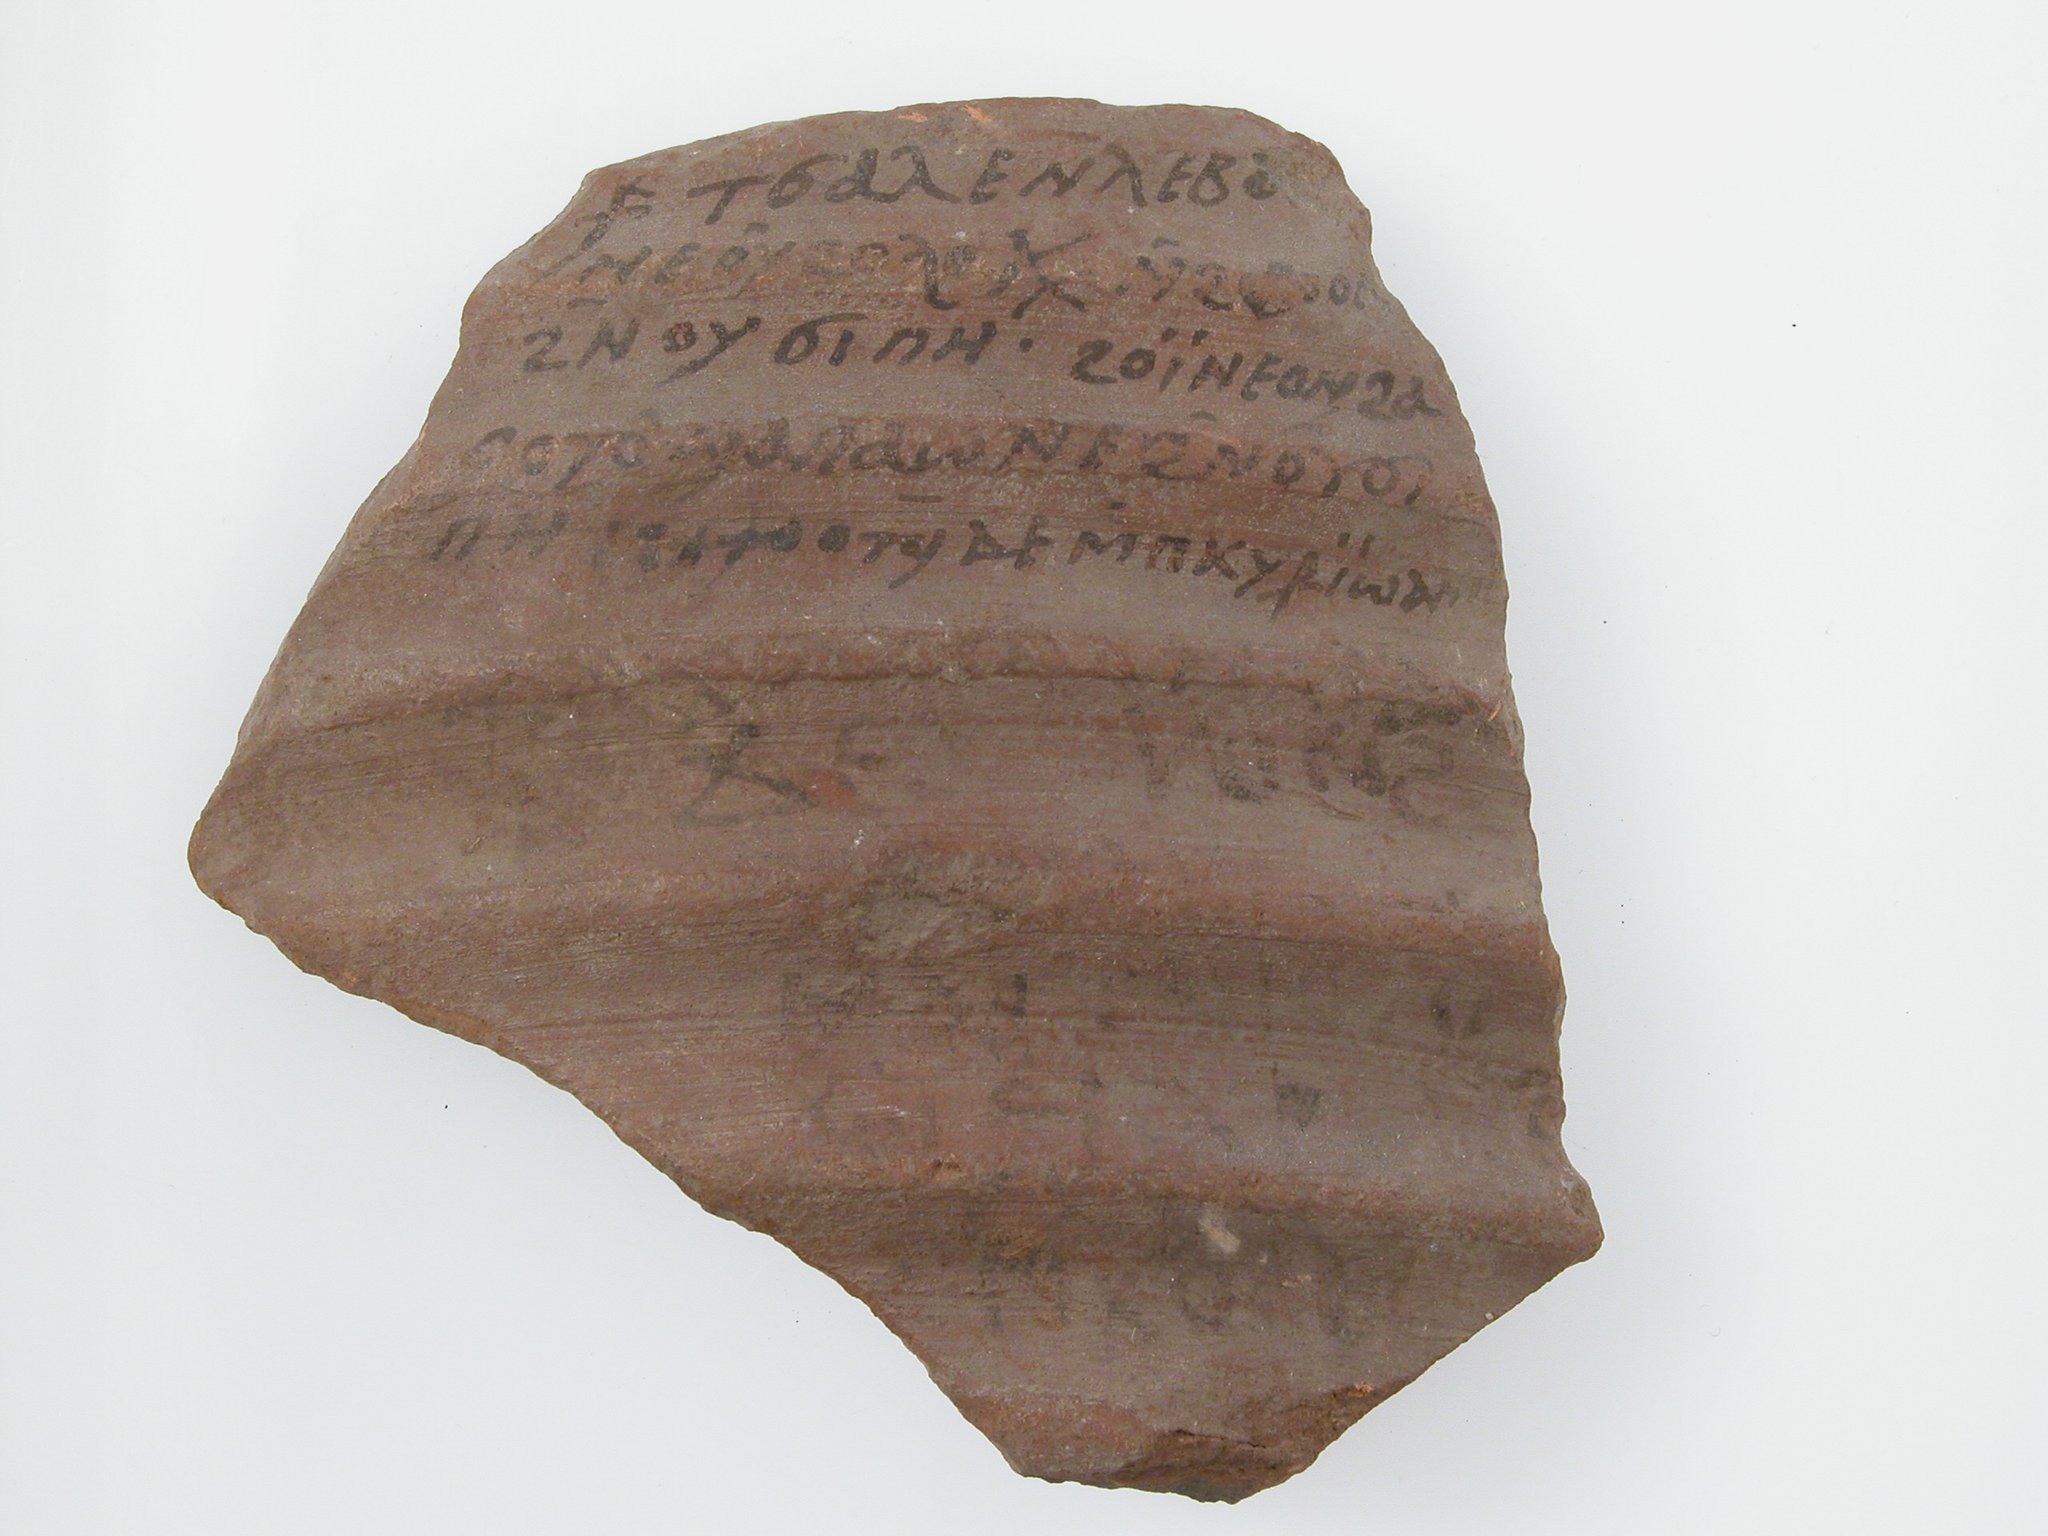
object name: ostrakon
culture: coptic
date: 601-700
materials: ink, pottery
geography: egypt